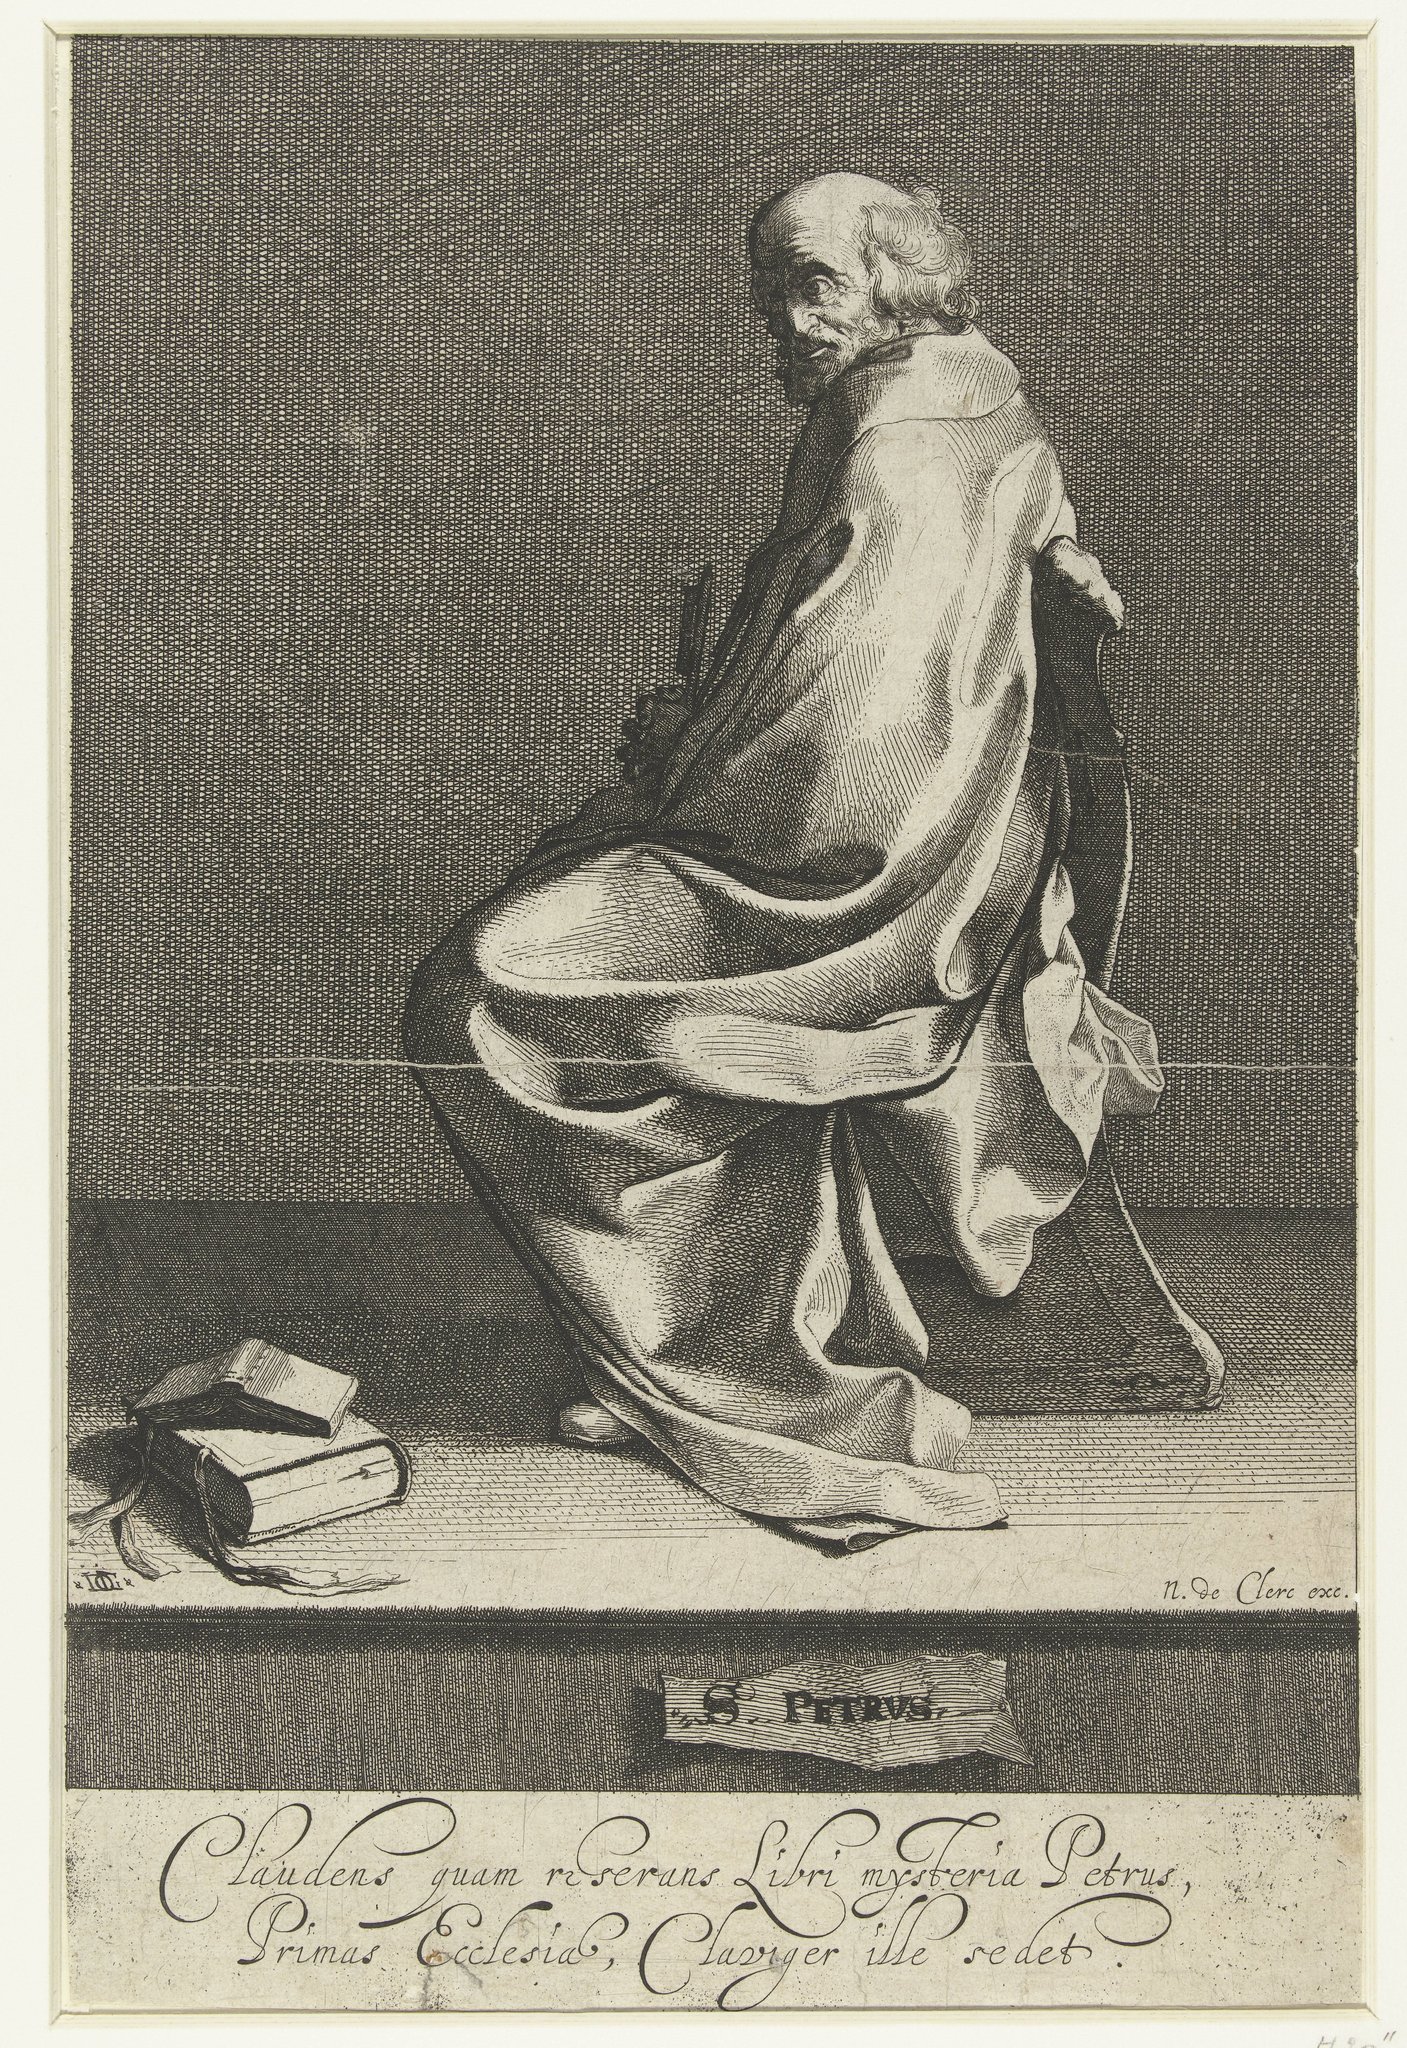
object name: print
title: S. petrus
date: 1616-1620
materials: paper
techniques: drypoint, etching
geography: netherlands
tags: the apostle peter, first bishop of rome; possible attributes: book, cock, (upturned) cross, (triple) crozier, fish, key, scroll, ship, tiara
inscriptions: collector's mark: Lugt 2228a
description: De apostel Petrus, ten voeten uit, op de linkerzijde gezien, zittende met een sleutel in de handen. Links op de voorgrond liggen twee boeken. Onderin de voorstelling op een banderol 'S. petrus'. Onder de voorstelling een tweeregelig onderschrift in Latijn. Deze prent heeft als pendant een prent van de apostel Paulus.